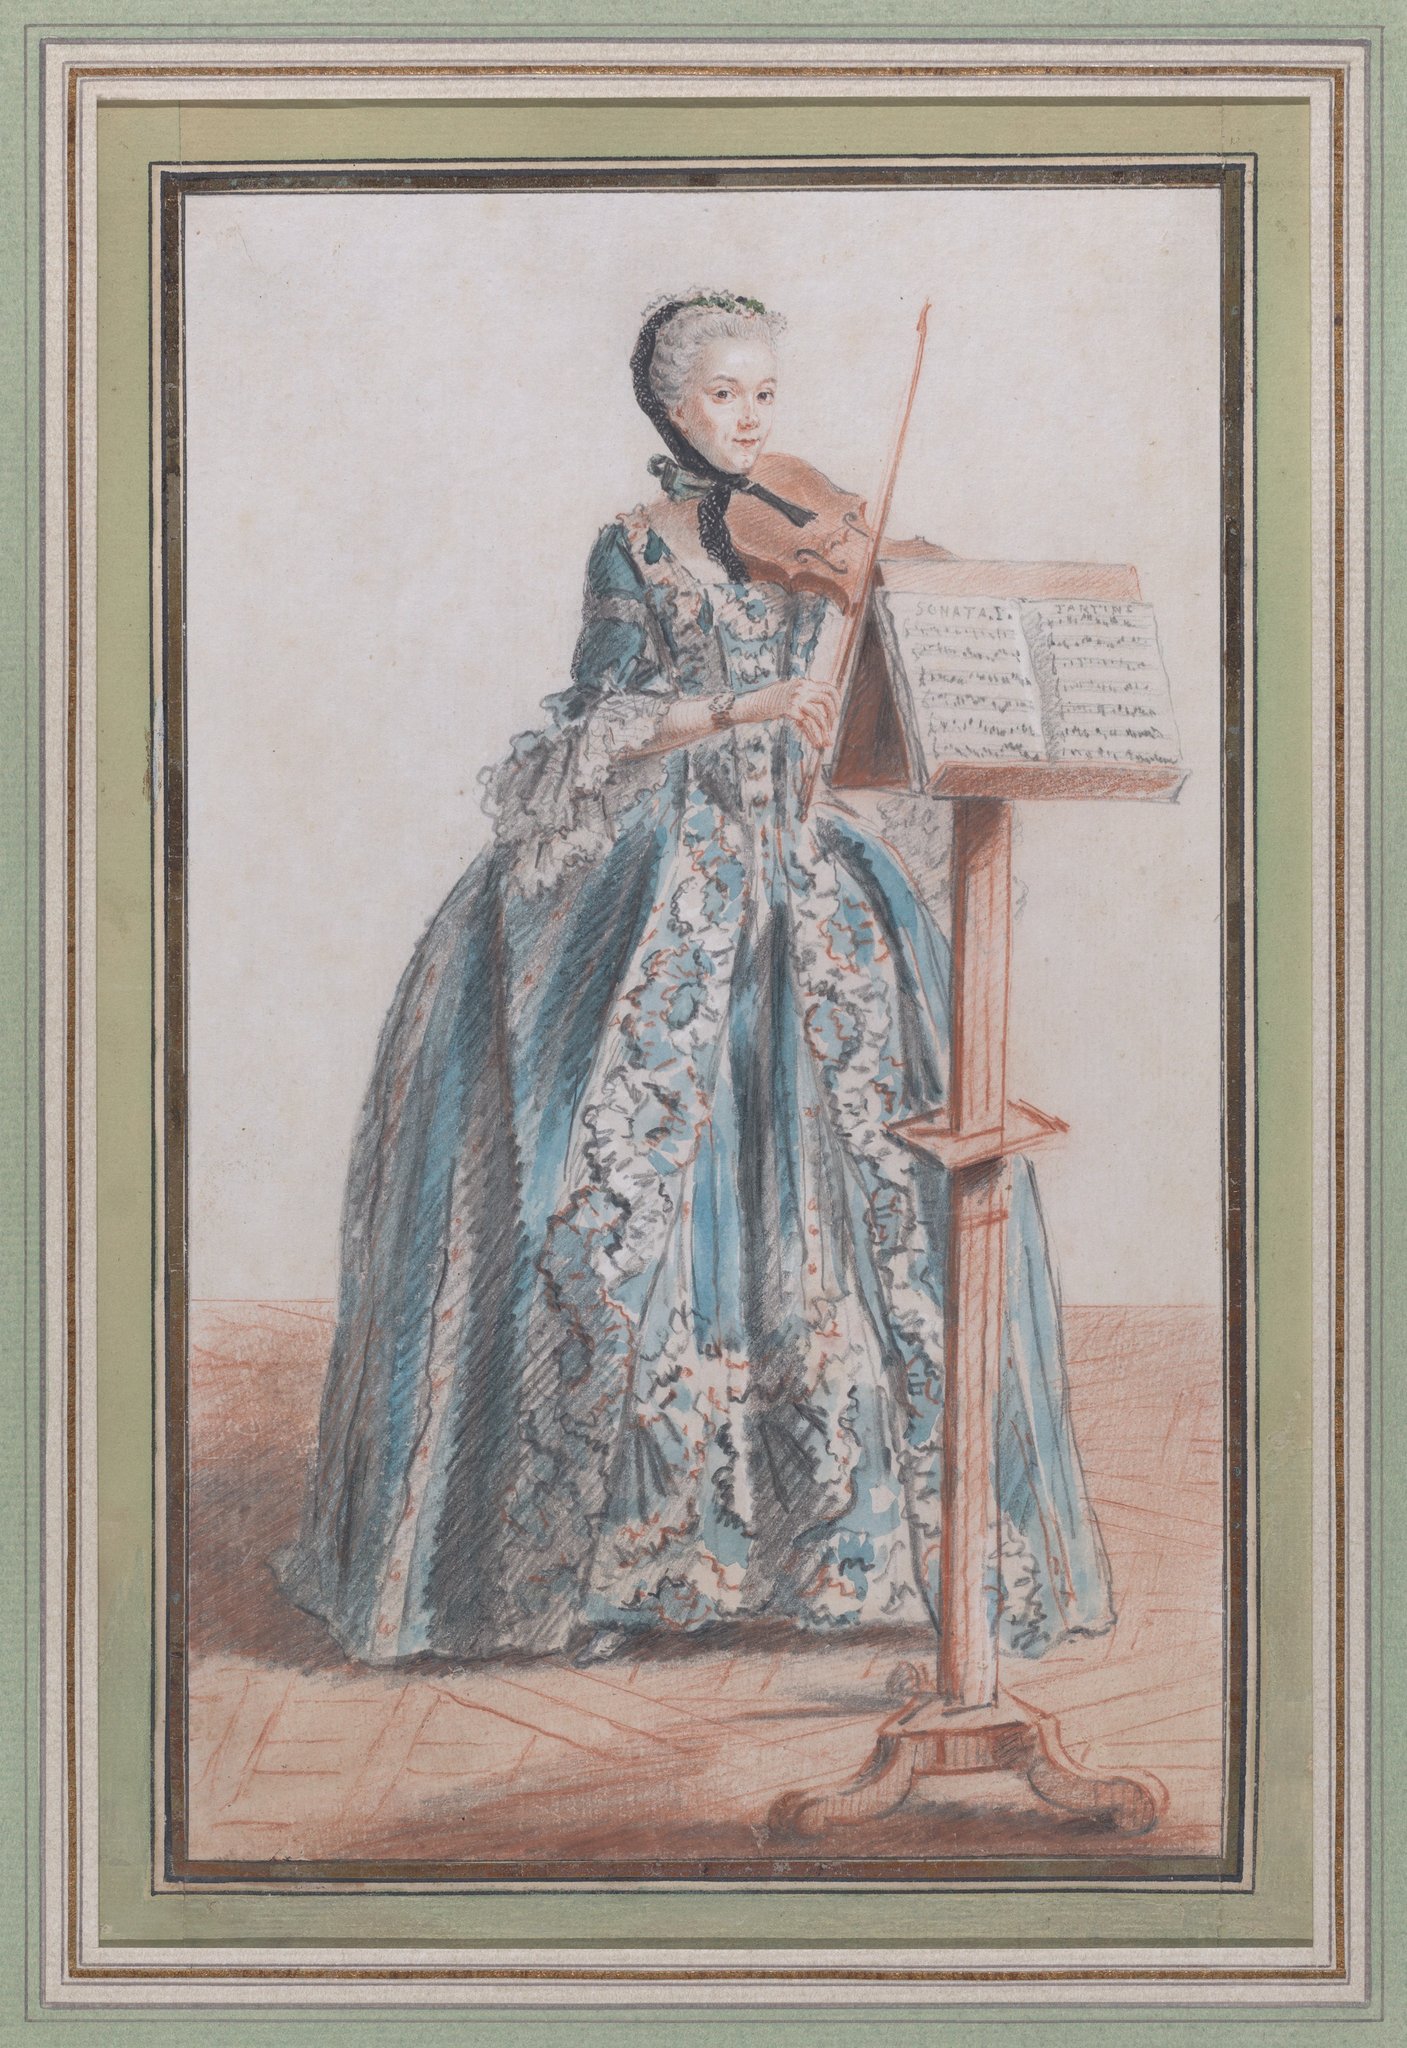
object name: drawing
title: Woman Playing the Violin, Seen from the Front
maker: louis de carmontelle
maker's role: artist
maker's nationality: french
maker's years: 1717-1806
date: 1758-1759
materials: chalk, graphite, watercolor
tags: women,violins,musicians